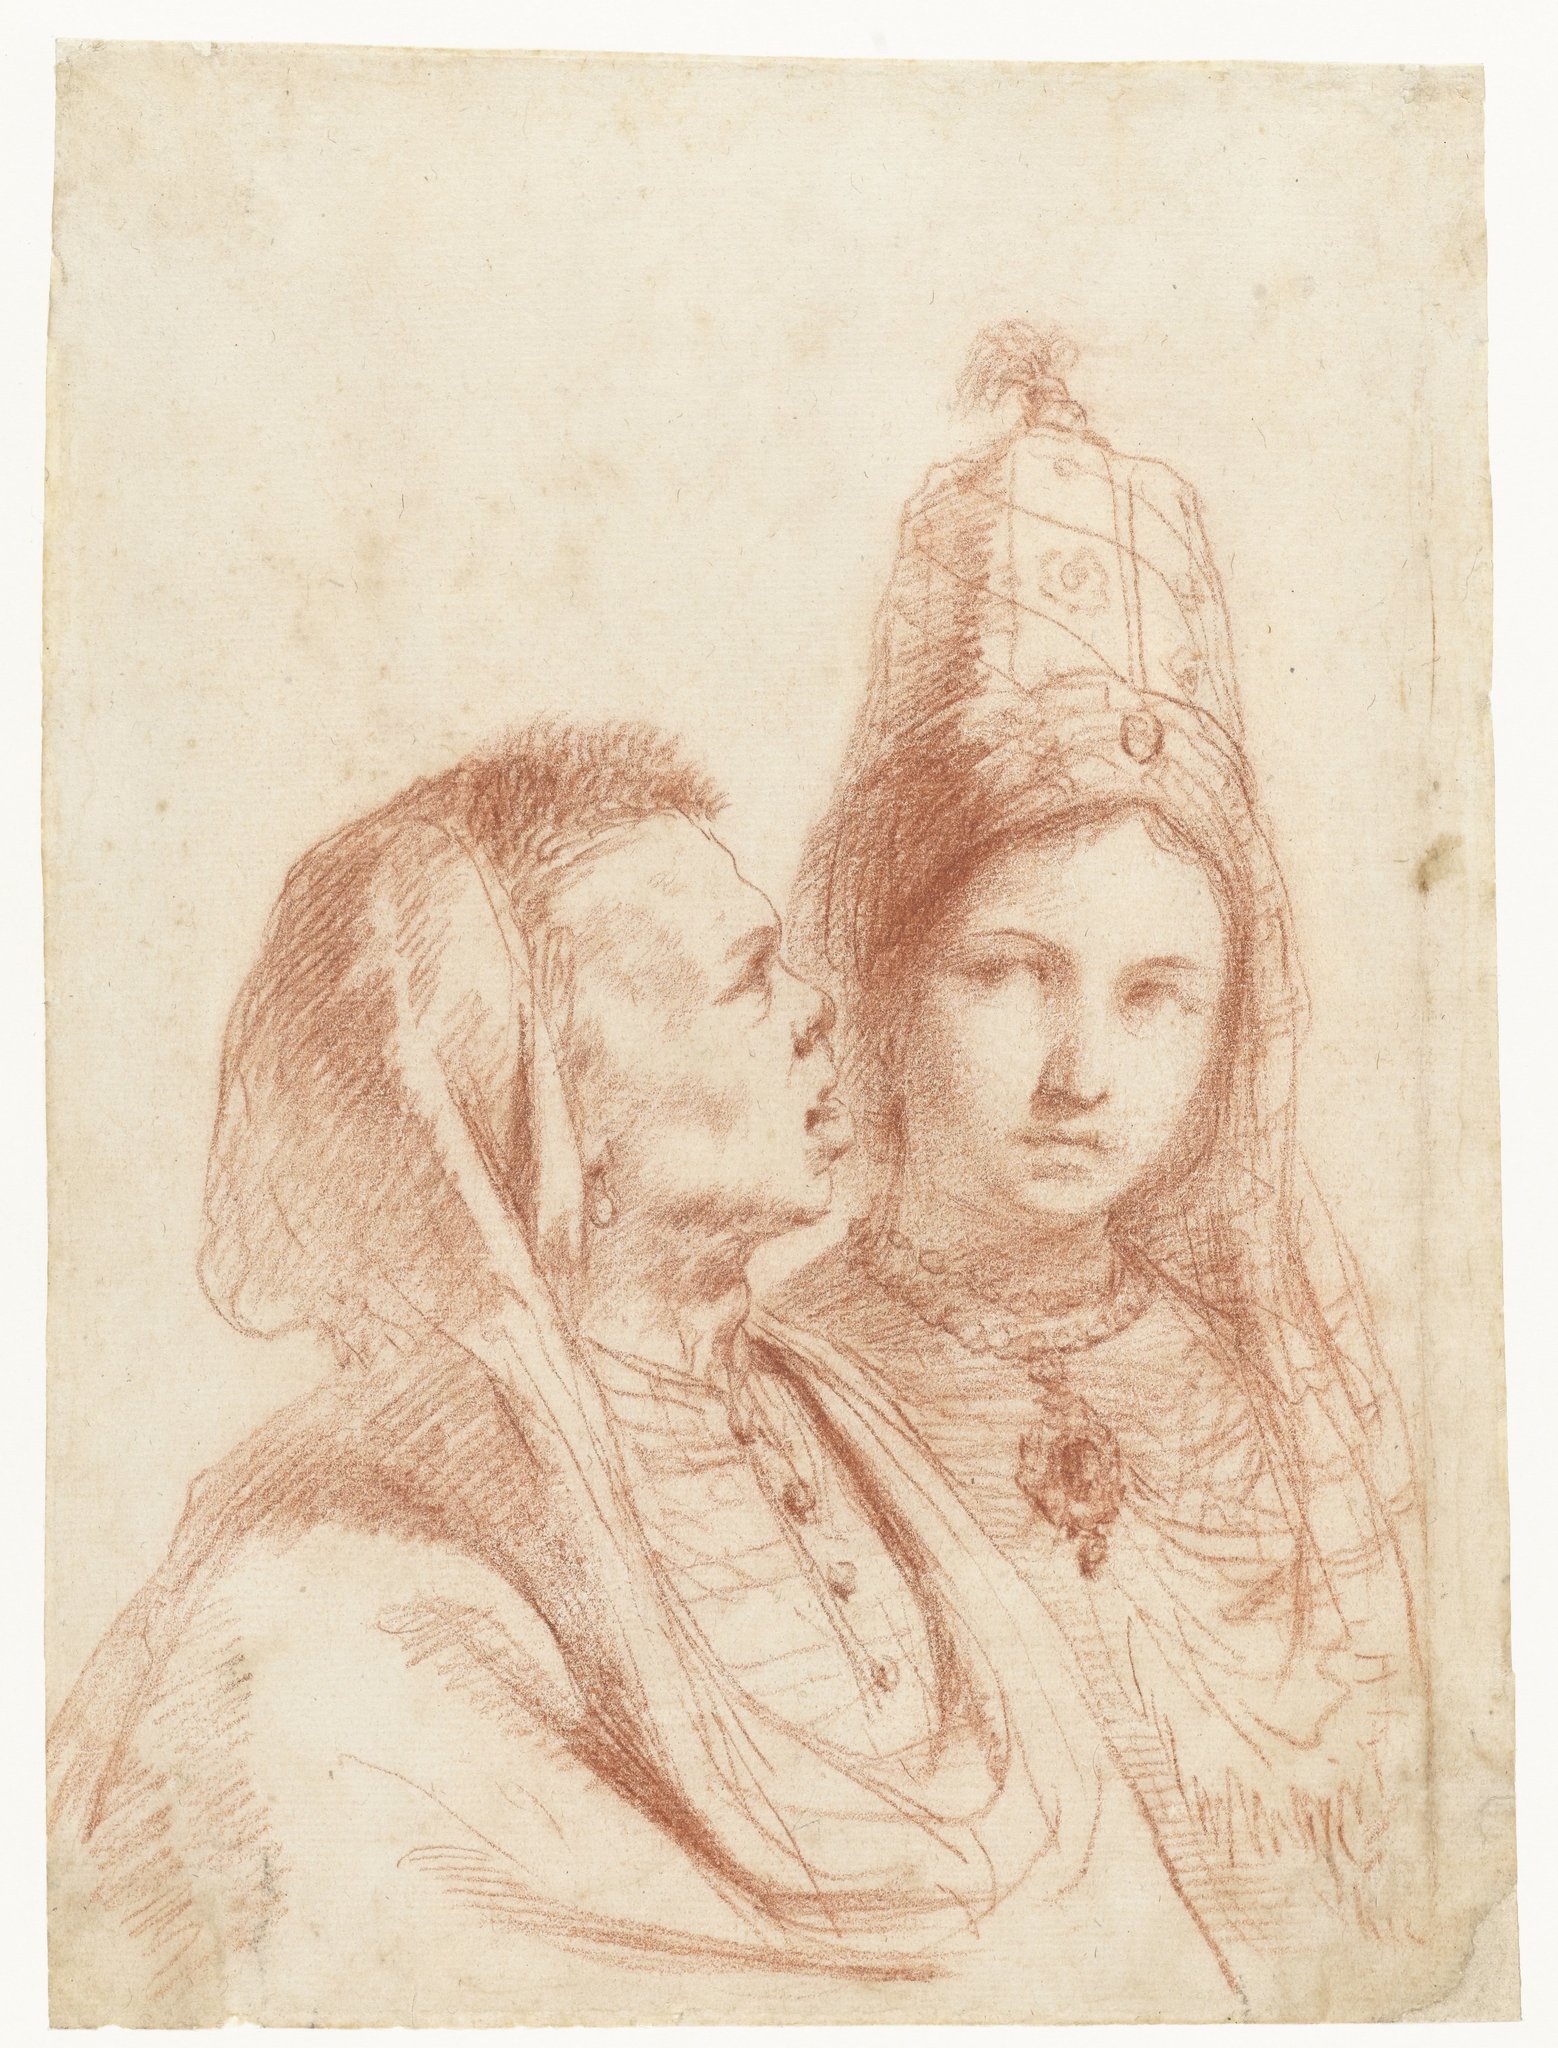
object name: drawing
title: Busts of a Man and a Woman in Exotic Costumes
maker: g.jo.franc da cento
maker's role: draughtsman, painter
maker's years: 1591-1666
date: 1645-1655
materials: chalk, paper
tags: folk costume, regional costume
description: In this drawing Guercino may have focused on a subject that was particularly popular with Northern artists: the ill-matched love between an unattractive old man and a beautiful young woman. The delicate use of red chalk indicates that the artist considered the drawing as an independent work of art; perhaps it was intended for sale.